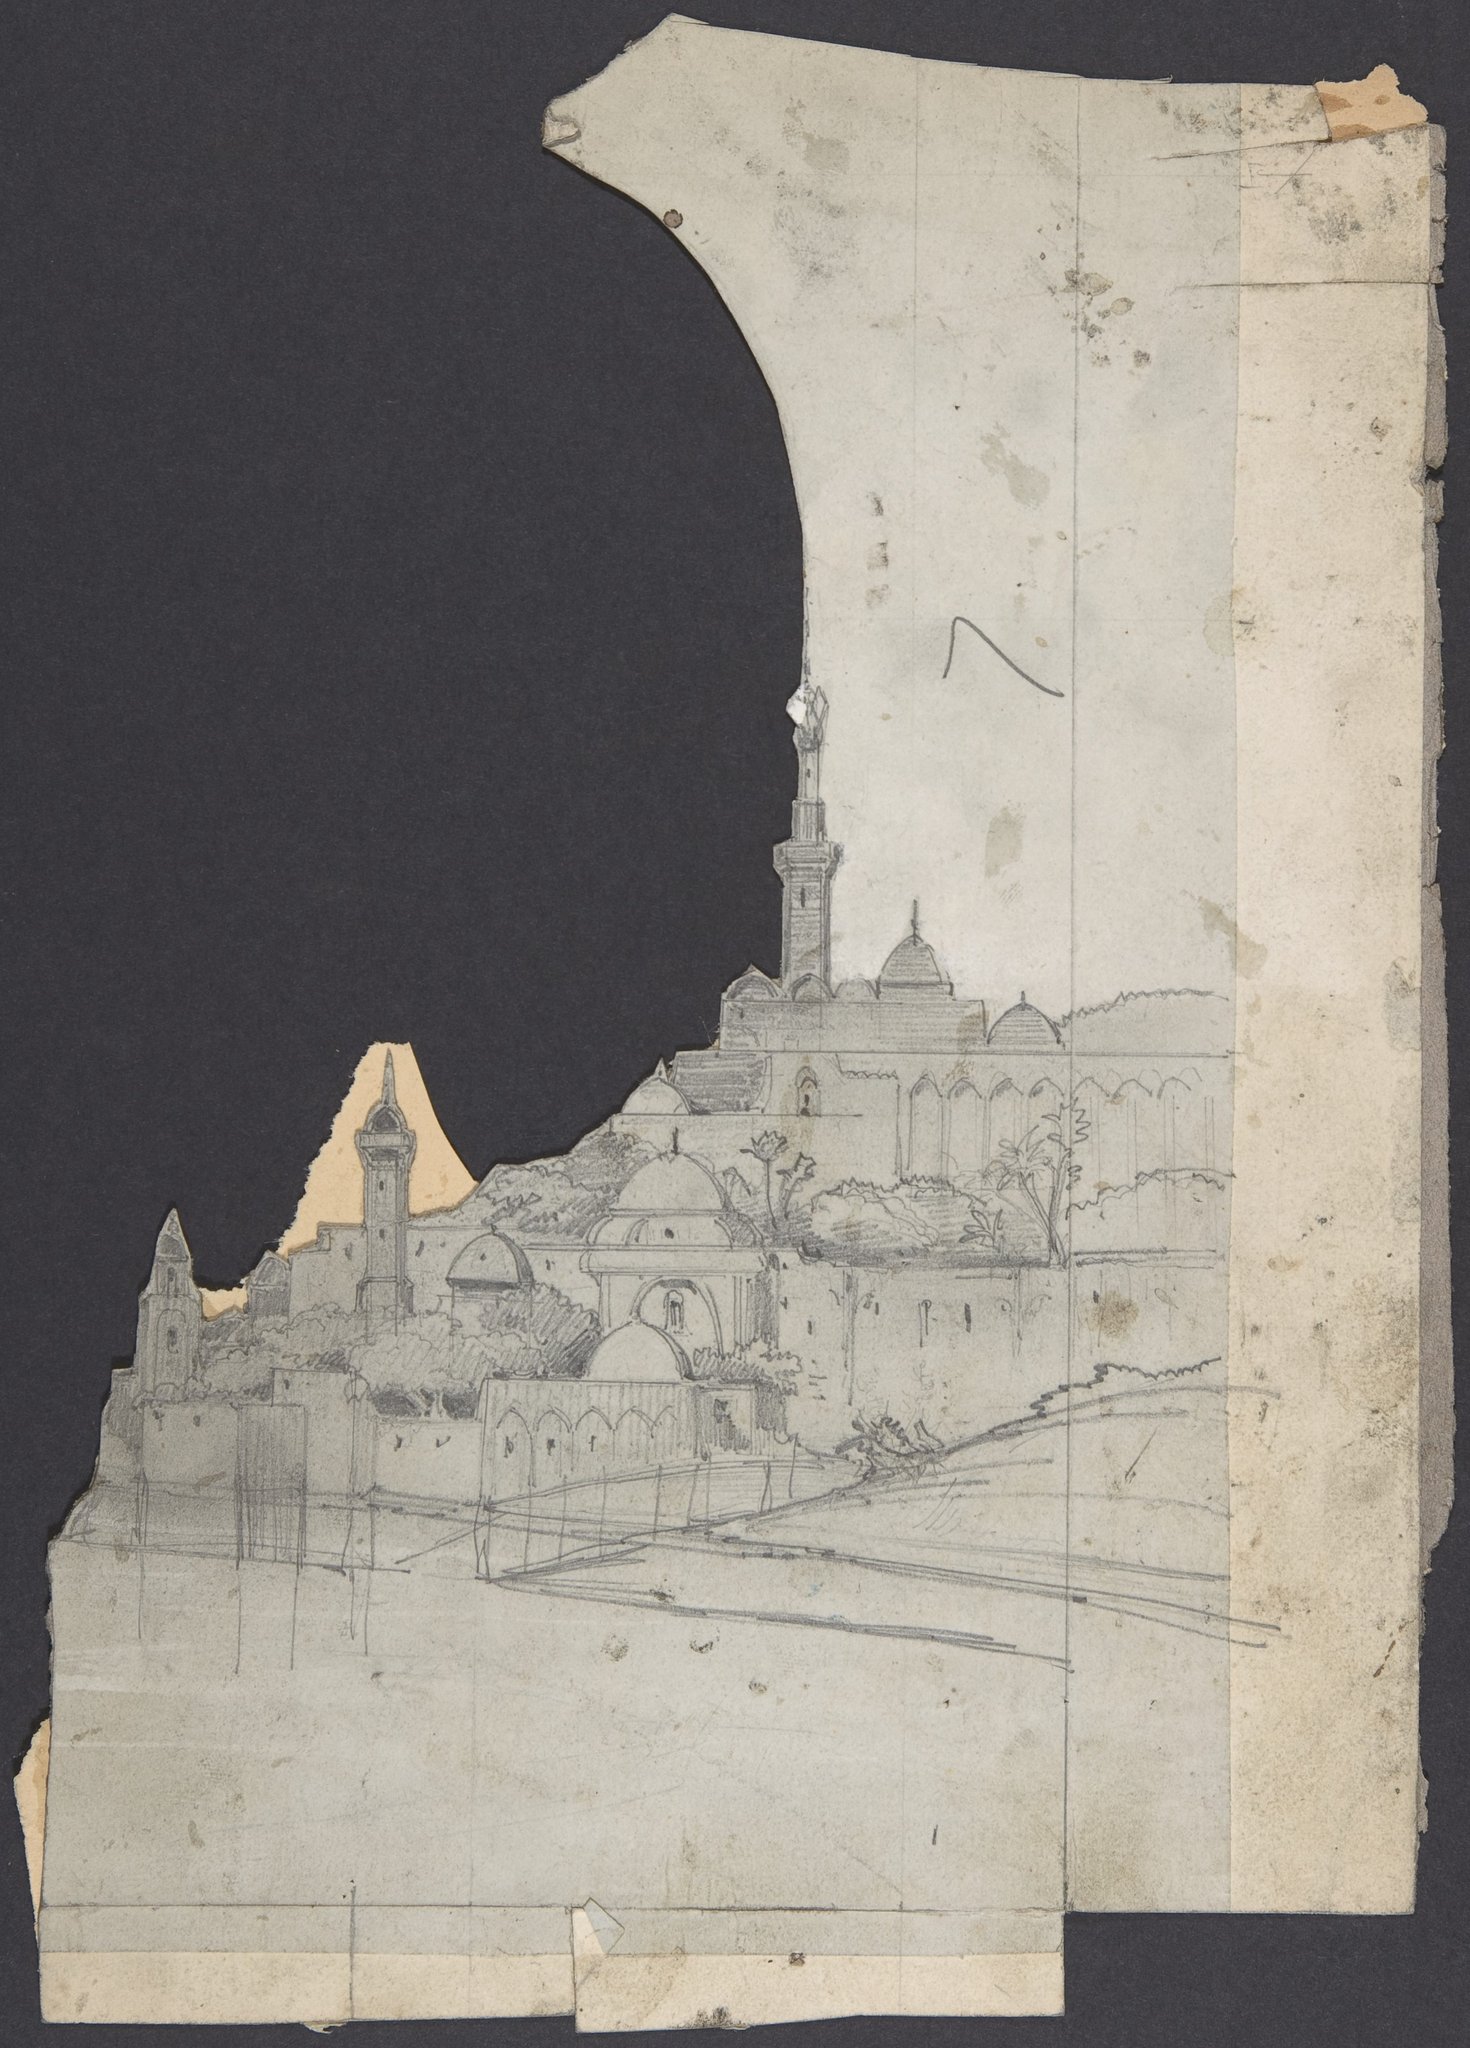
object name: drawing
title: Design for a Stage Set at the Opéra, Paris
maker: eugène cicéri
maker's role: artist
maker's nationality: french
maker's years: 1813-1890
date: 1830-1890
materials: graphite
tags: stage design